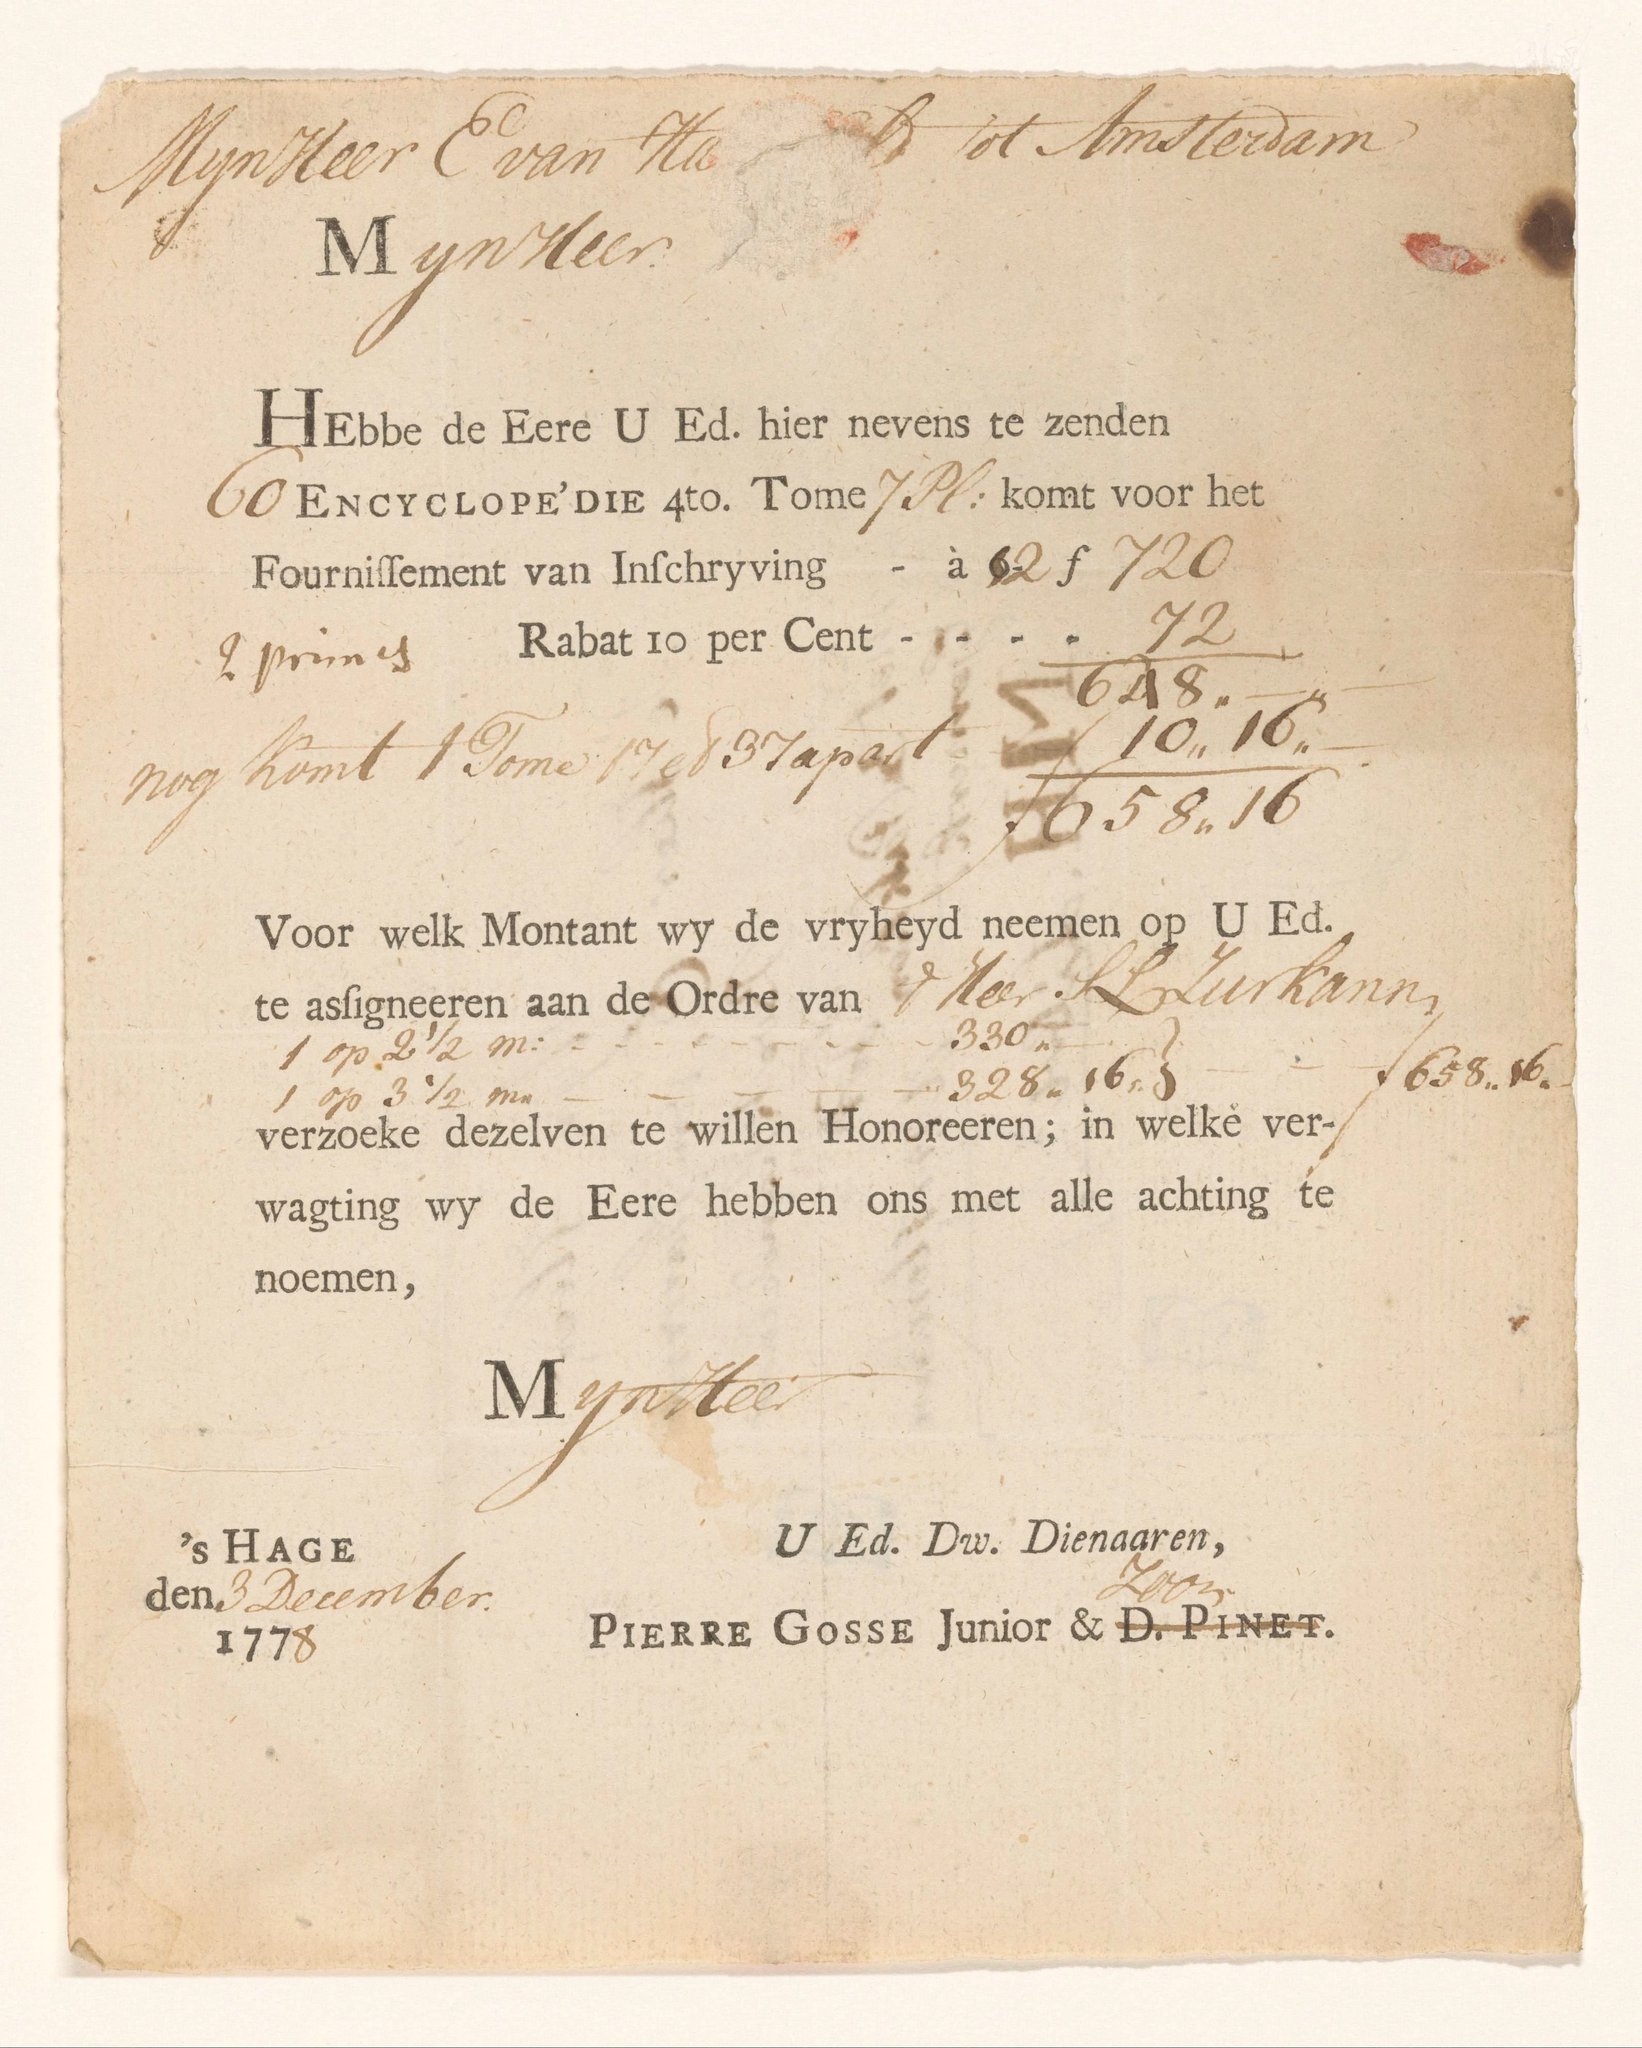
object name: ontvangstbewijs, kwitantie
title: Kwitantie voor de levering van een encyclopedie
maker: pierre gosse jr.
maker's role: publisher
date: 1778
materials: ink, paper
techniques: letterpress printing, pen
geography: the hague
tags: evert van harrevelt, pierre gosse jr.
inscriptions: collector's mark: Lugt 4779, collector's mark: Lugt 2228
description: Kwitantie voor een 60-delige encyclopedie, geleverd door de Haagse boekhandelaar Pierre Gosse Junior aan de Amsterdamse boekverkoper E. van Harrevelt, bestemd voor S.L. Zurkann.